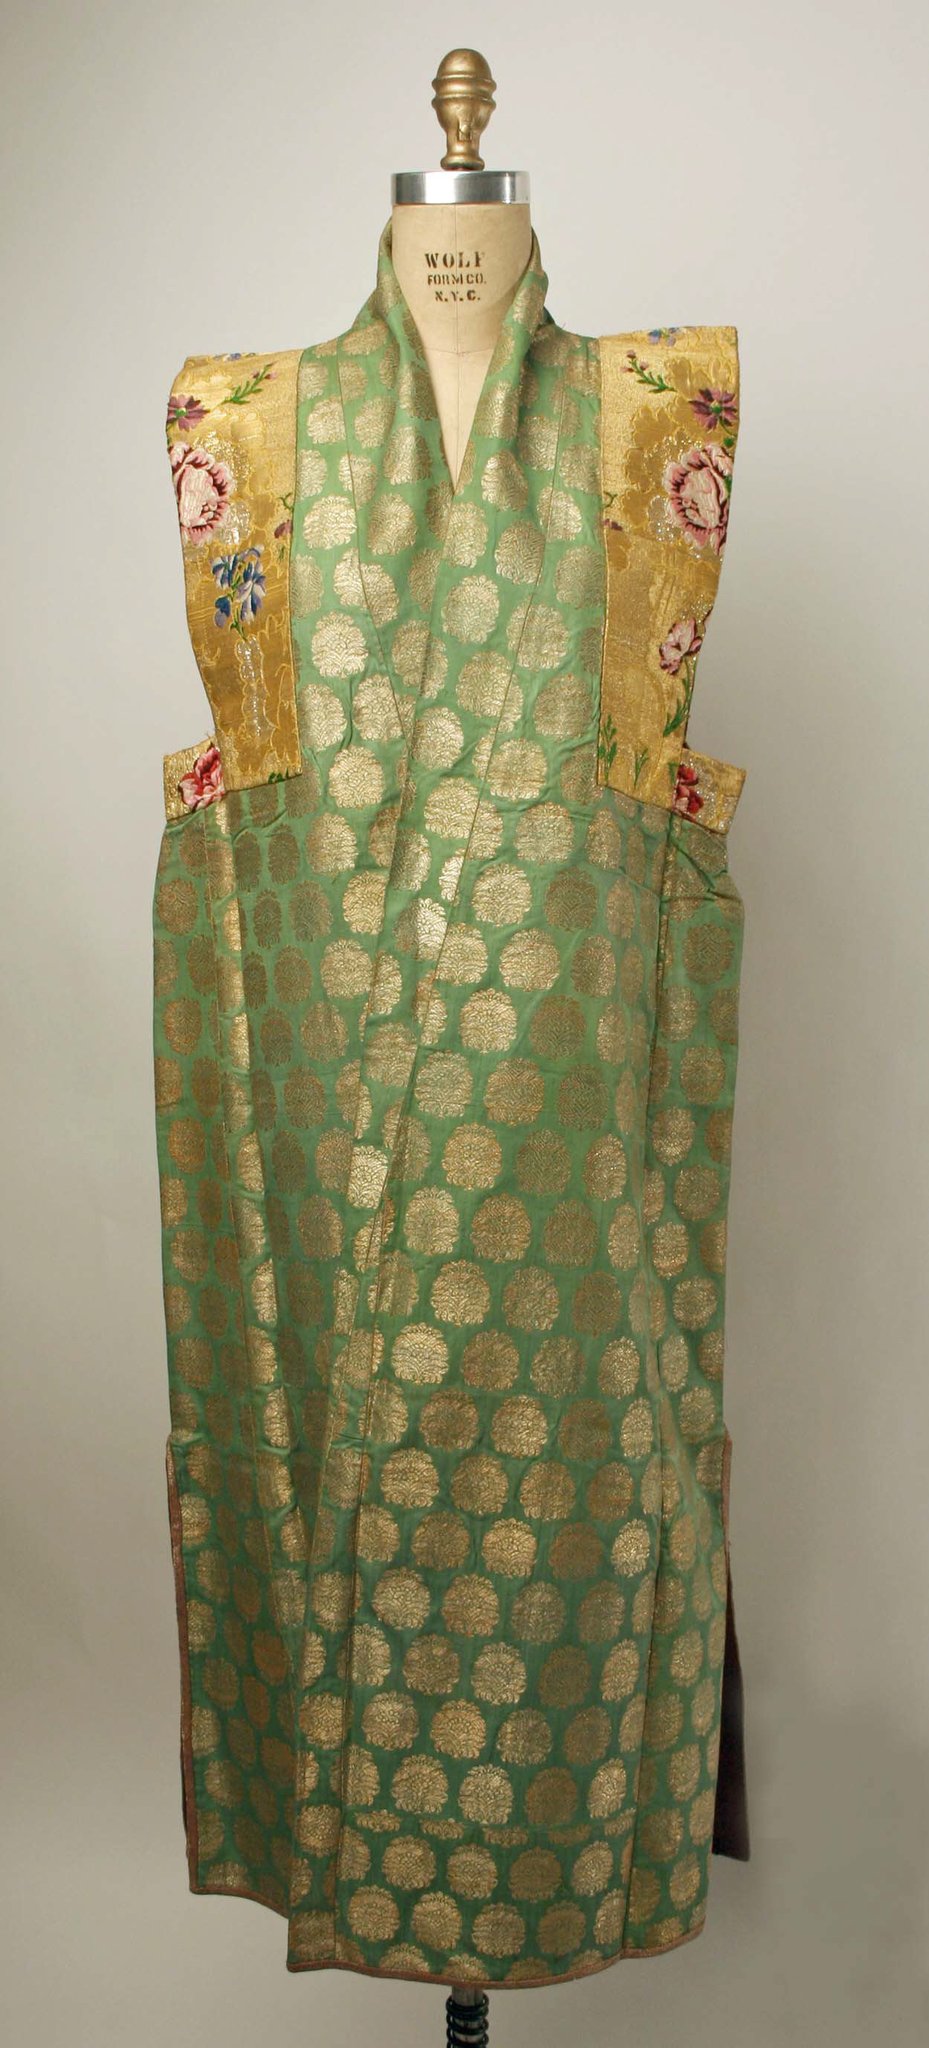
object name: dress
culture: tibetan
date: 1850-1875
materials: metal, silk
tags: dresses,flowers